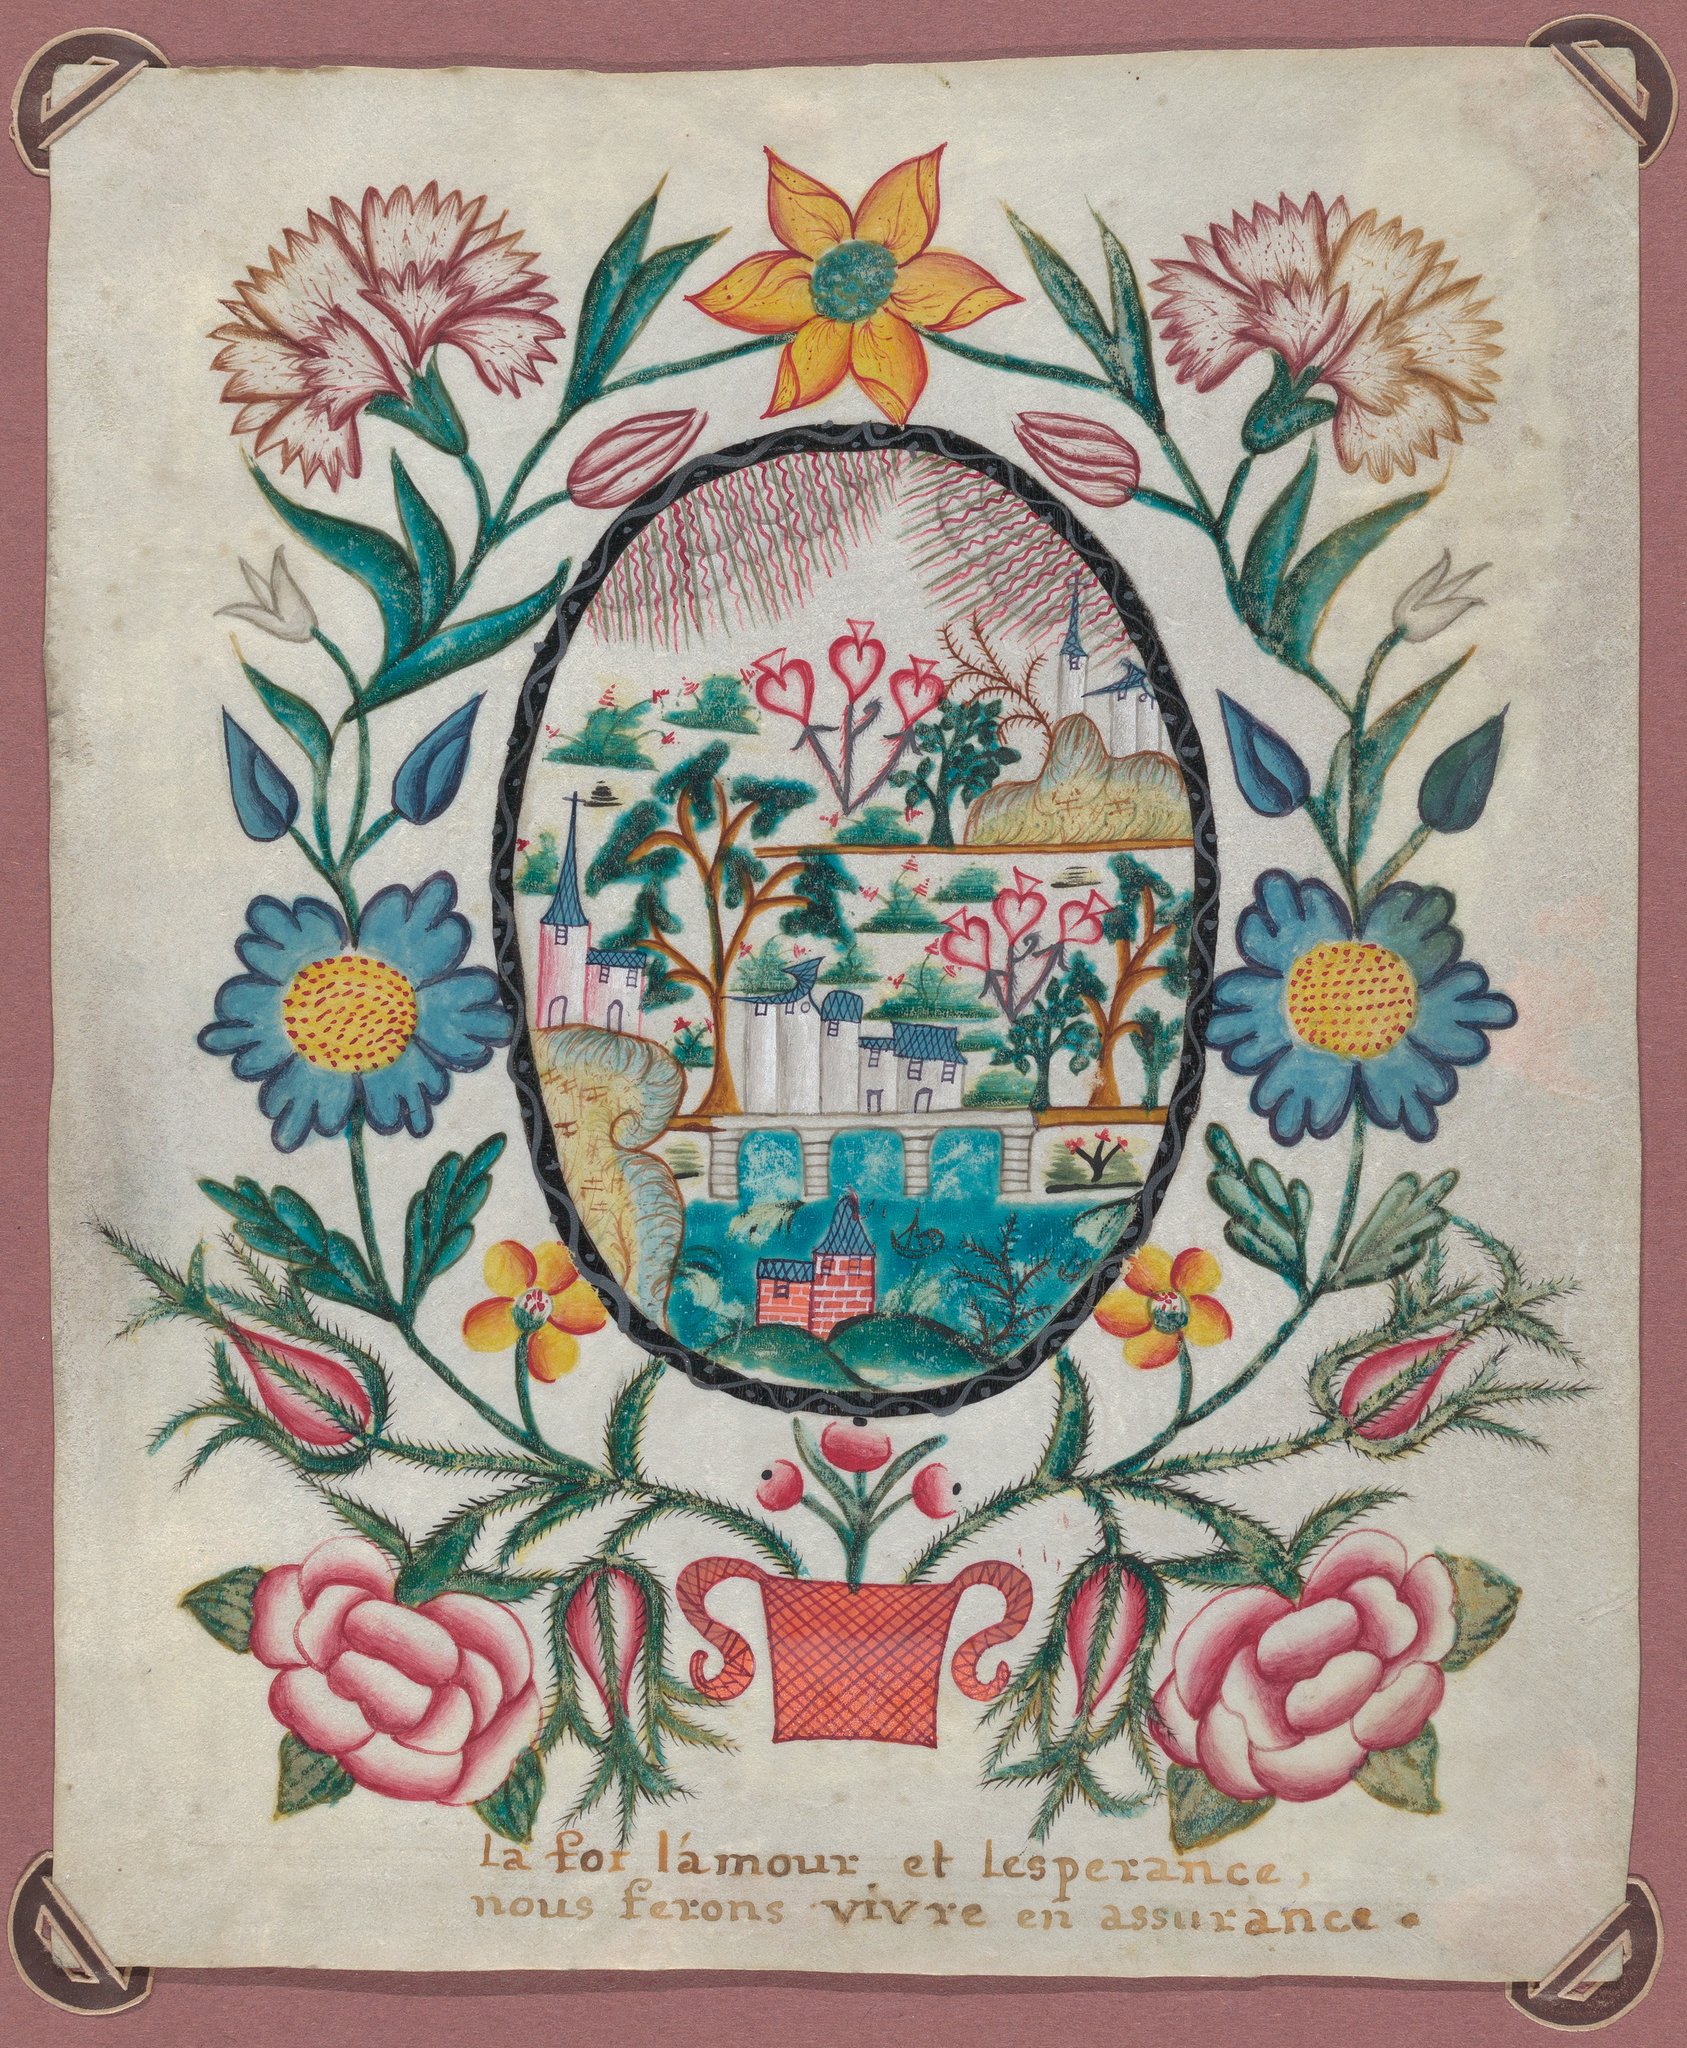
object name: valentine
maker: anonymous, french, 18th century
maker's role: artist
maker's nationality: french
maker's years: 1700-1800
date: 1775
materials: ink, parchment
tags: flowers,landscapes